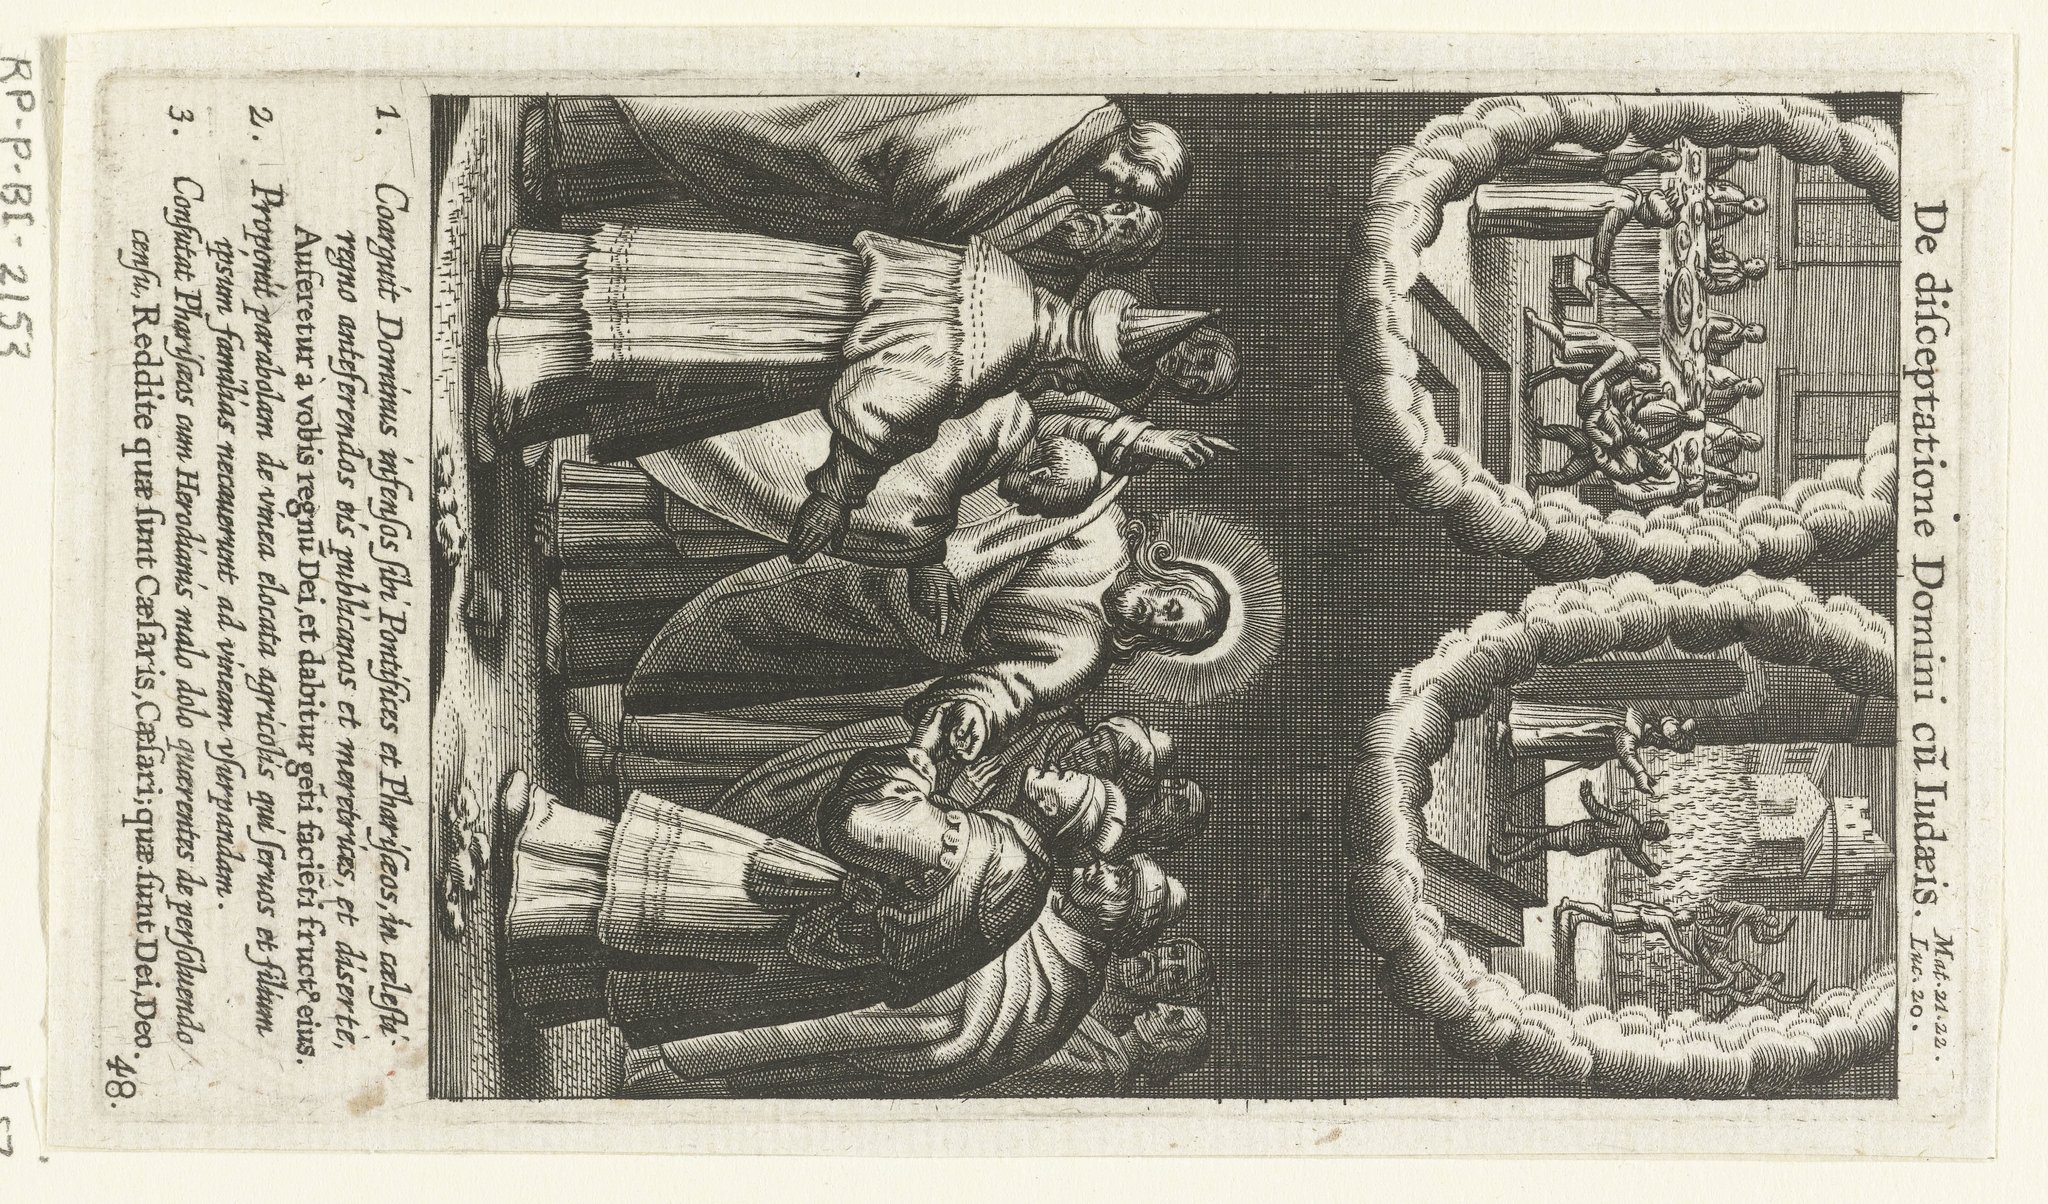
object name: book illustration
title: De disceptatione Domini cu Iudaeis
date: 1590-1622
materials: paper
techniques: engraving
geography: antwerp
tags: the great supper; the royal wedding-feast ~ parable of christ (matthew 22:1-14; luke 14:16-24)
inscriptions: collector's mark: Lugt 240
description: Prent uit: Joannes Bourgois, Vitae passionis et mortis Jesu Christi Somini nostri mysteria, Antwerpen Hendrick Aertssens, 1622, afb. 48